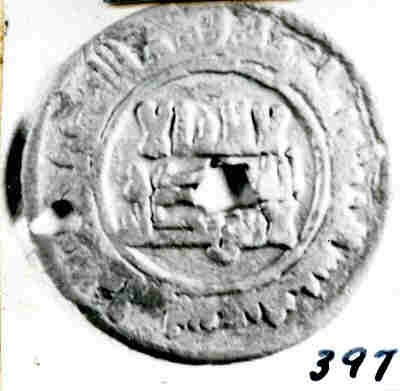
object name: coin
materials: copper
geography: uzbekistan